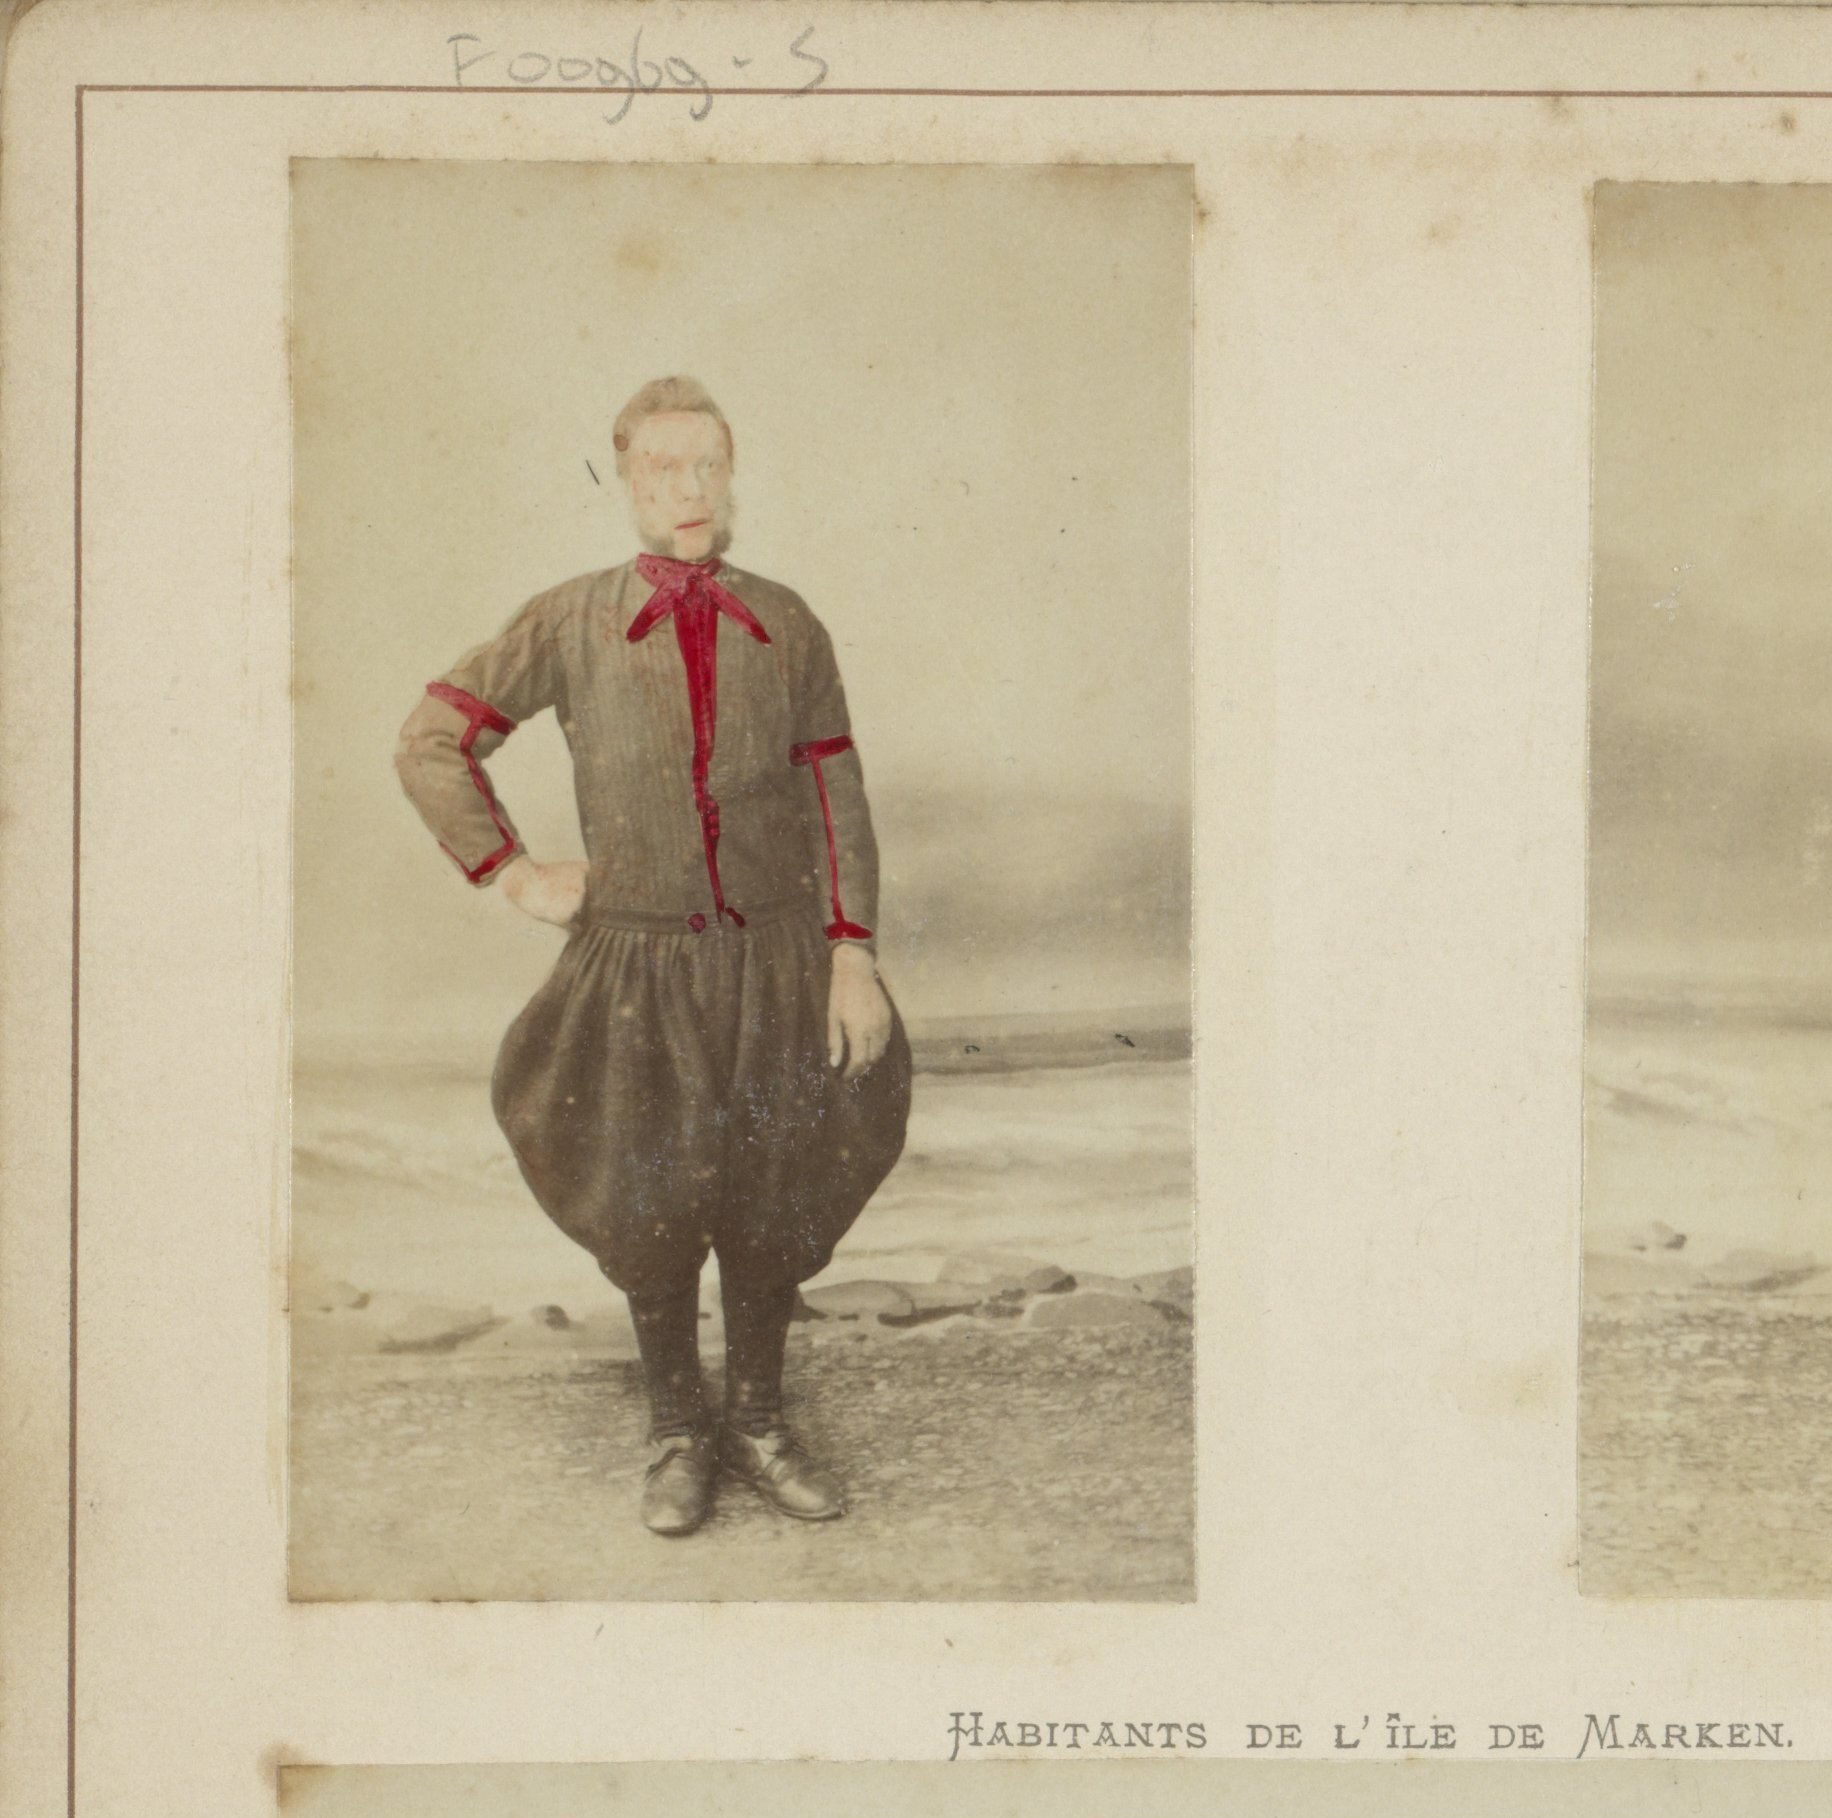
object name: photograph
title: Portret van een man in de klederdracht van Marken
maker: andries jager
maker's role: publisher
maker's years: 1825-1905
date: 1878-1890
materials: cardboard, paper, photographic support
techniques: albumen print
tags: studio requisites ~ photographer, historical persons, shoes, sandals, folk costume, regional costume, fisherman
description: Onderdeel van Leporelloalbum met 28 foto's van Amsterdam en omstreken.